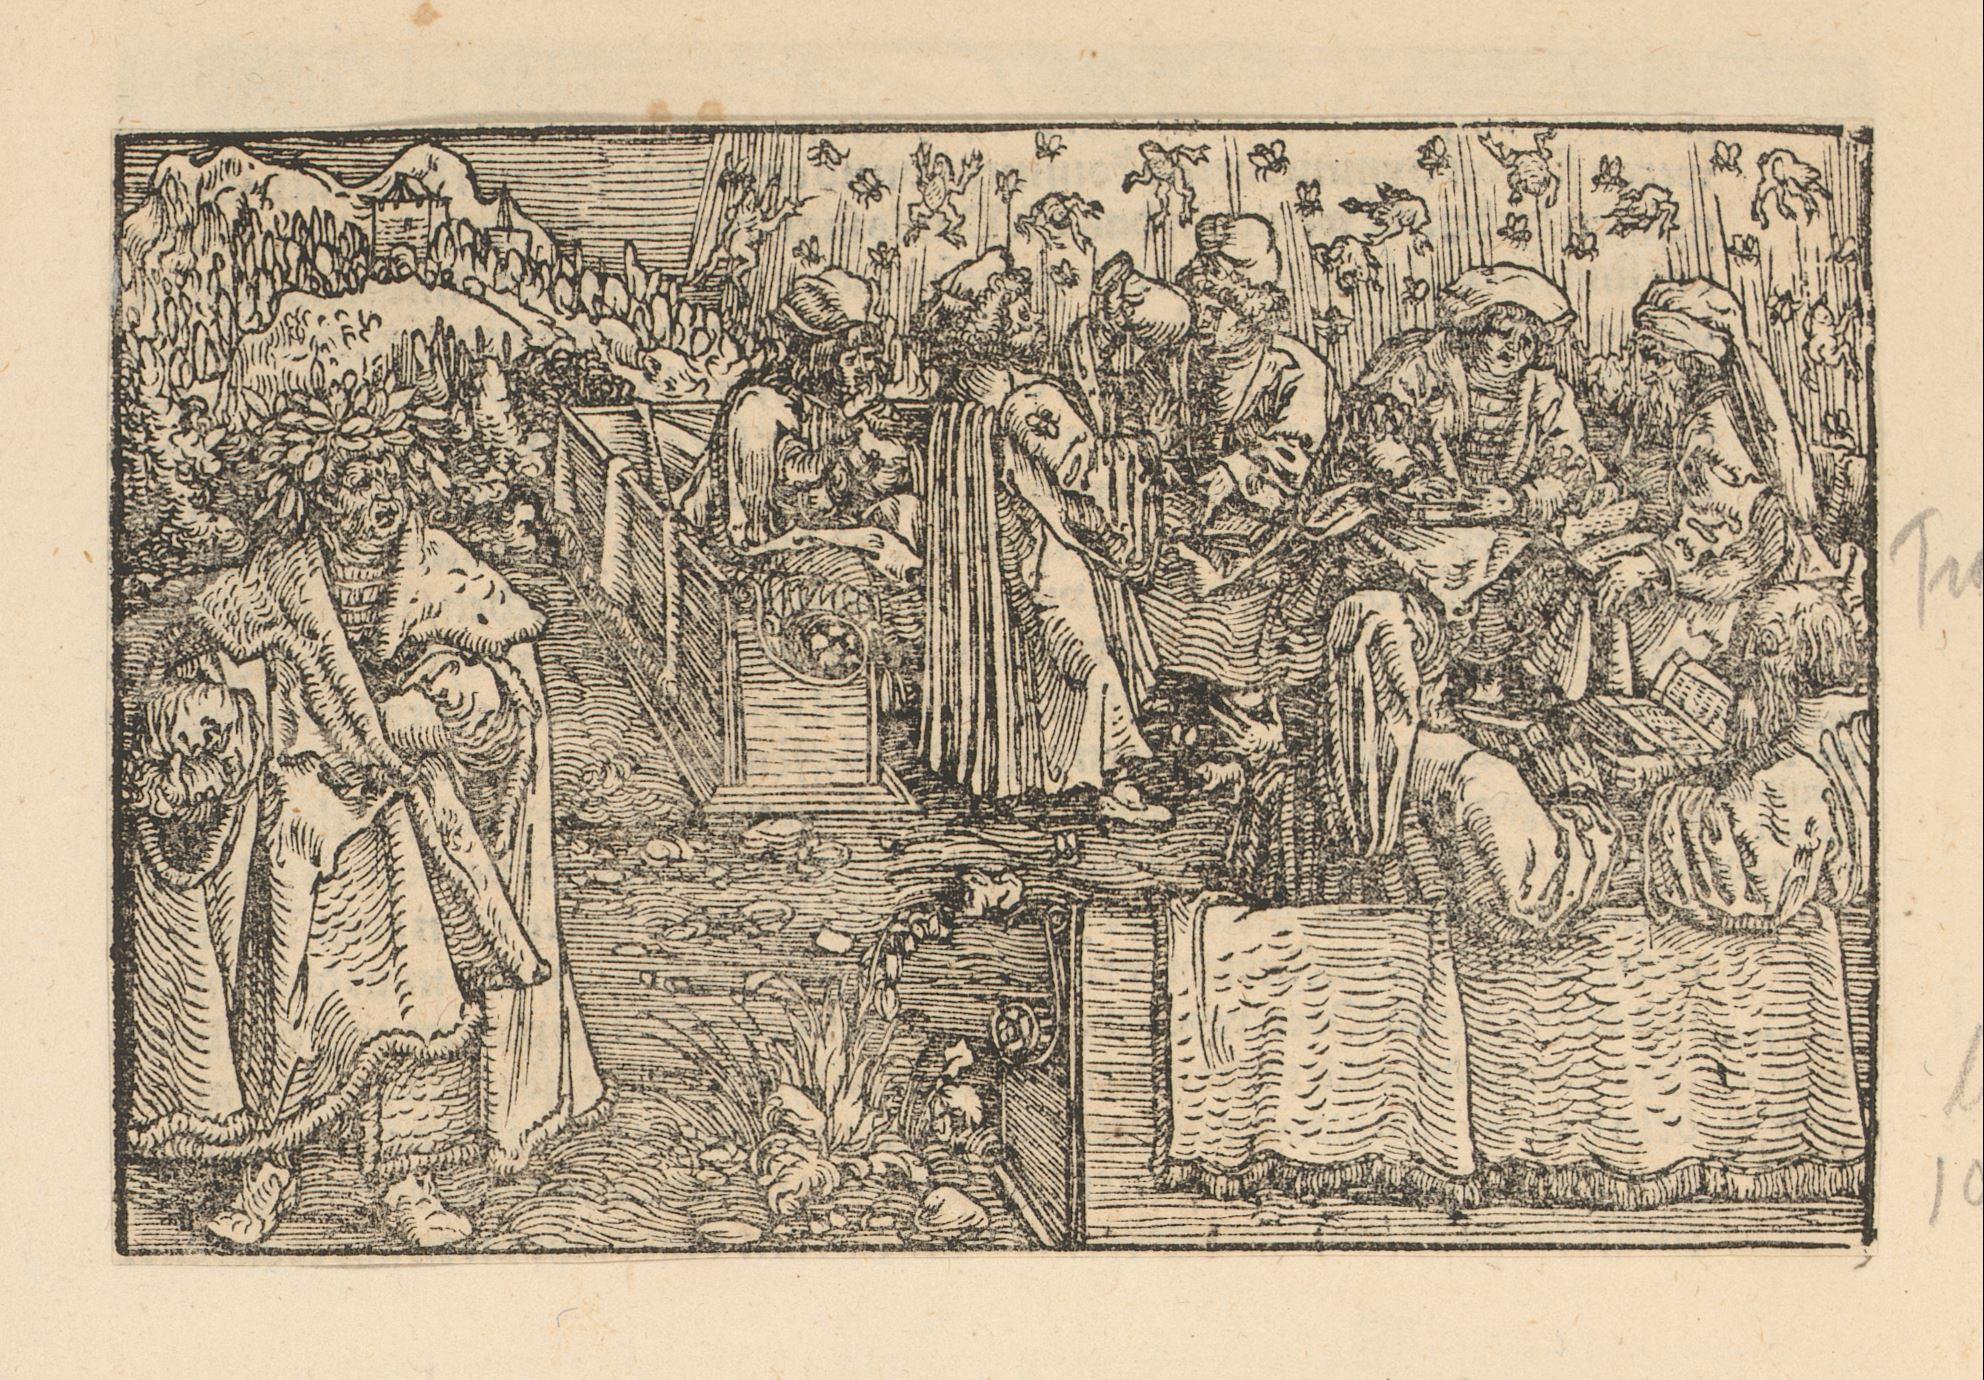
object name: book illustration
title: Geleerden zittend op banken terwijl er kikkers uit de lucht vallen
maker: Anonymous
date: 1514-1532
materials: paper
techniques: letterpress printing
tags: the plague of frogs: aaron stretches out his hand over the water of egypt; frogs come out and cover the land, mysterious rain, hail, etc.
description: Deze prent is gebruikt in: Petrarca, Francesco. Von der Artzney bayder Glück, des guten und widerwertigen: unnd weß sich ain yeder inn Gelück und Unglück halten sol (...). Augsburg: Heinrich Steiner, 1532. Deze uitgave is ook bekend onder de titel 'Trostspiegel in Glück und Unglück'.